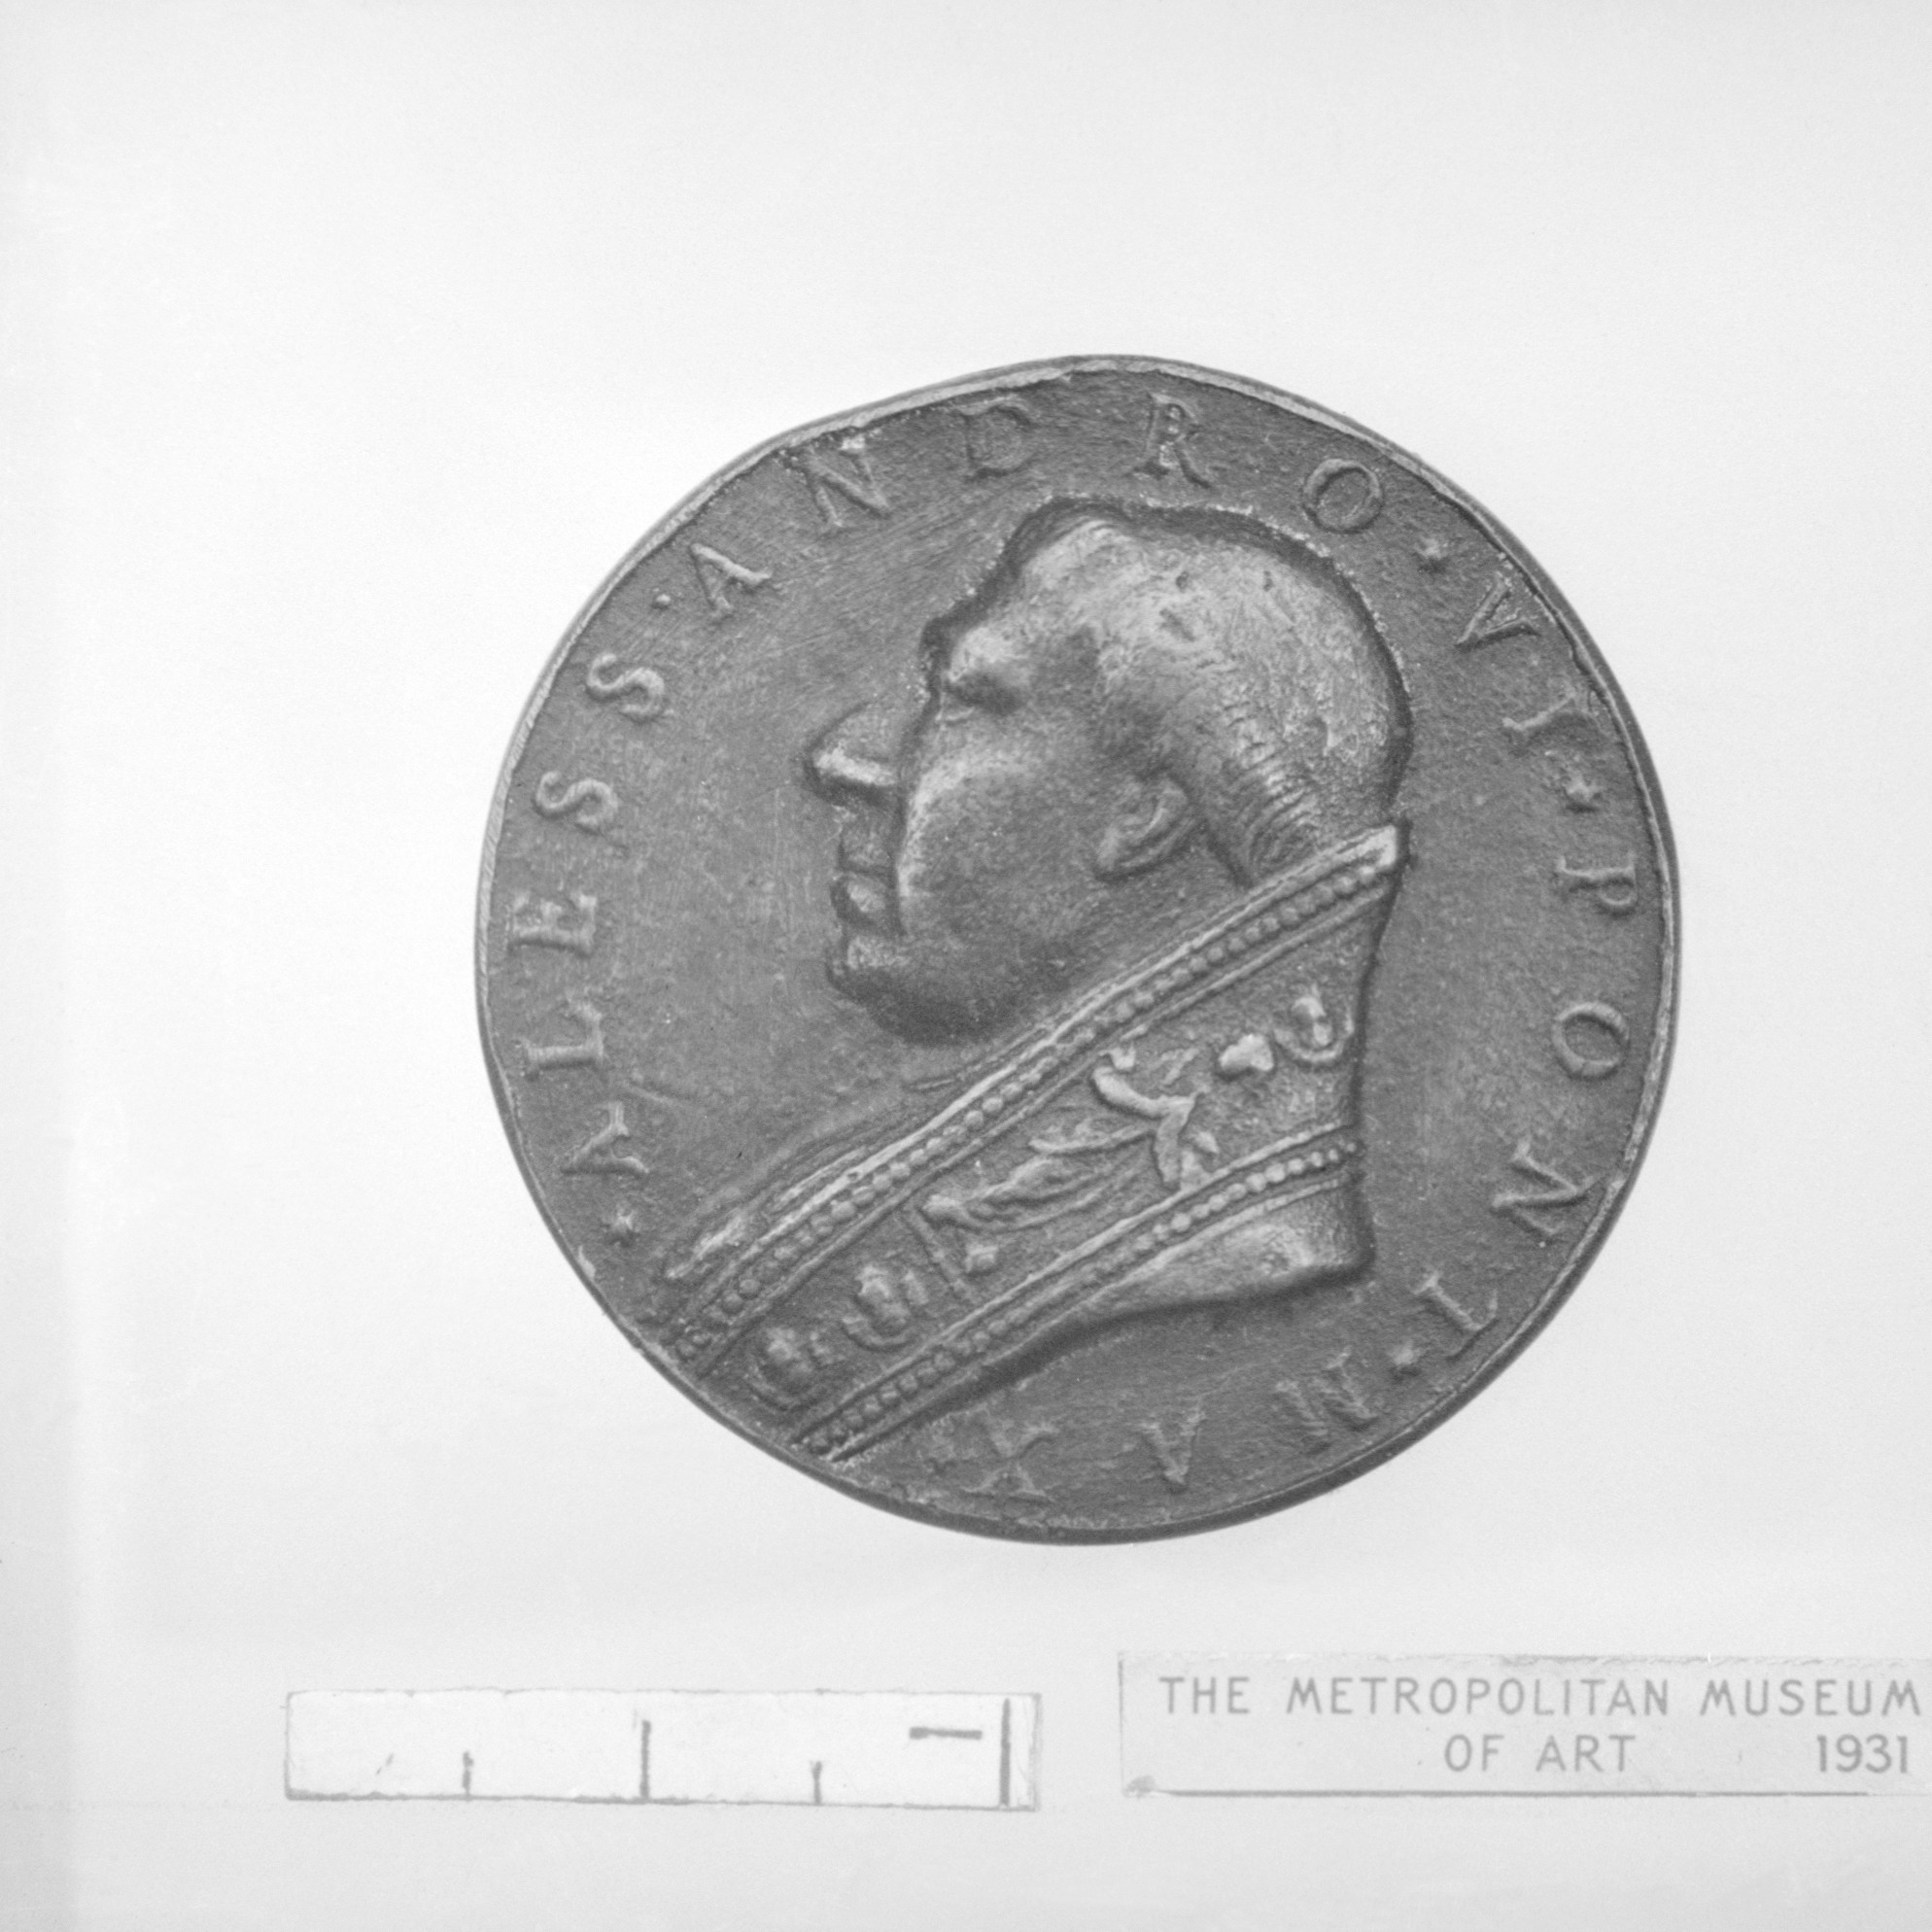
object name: medal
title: Pope Alexander VI (1492–1503)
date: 1467-1500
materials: bronze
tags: profiles,popes